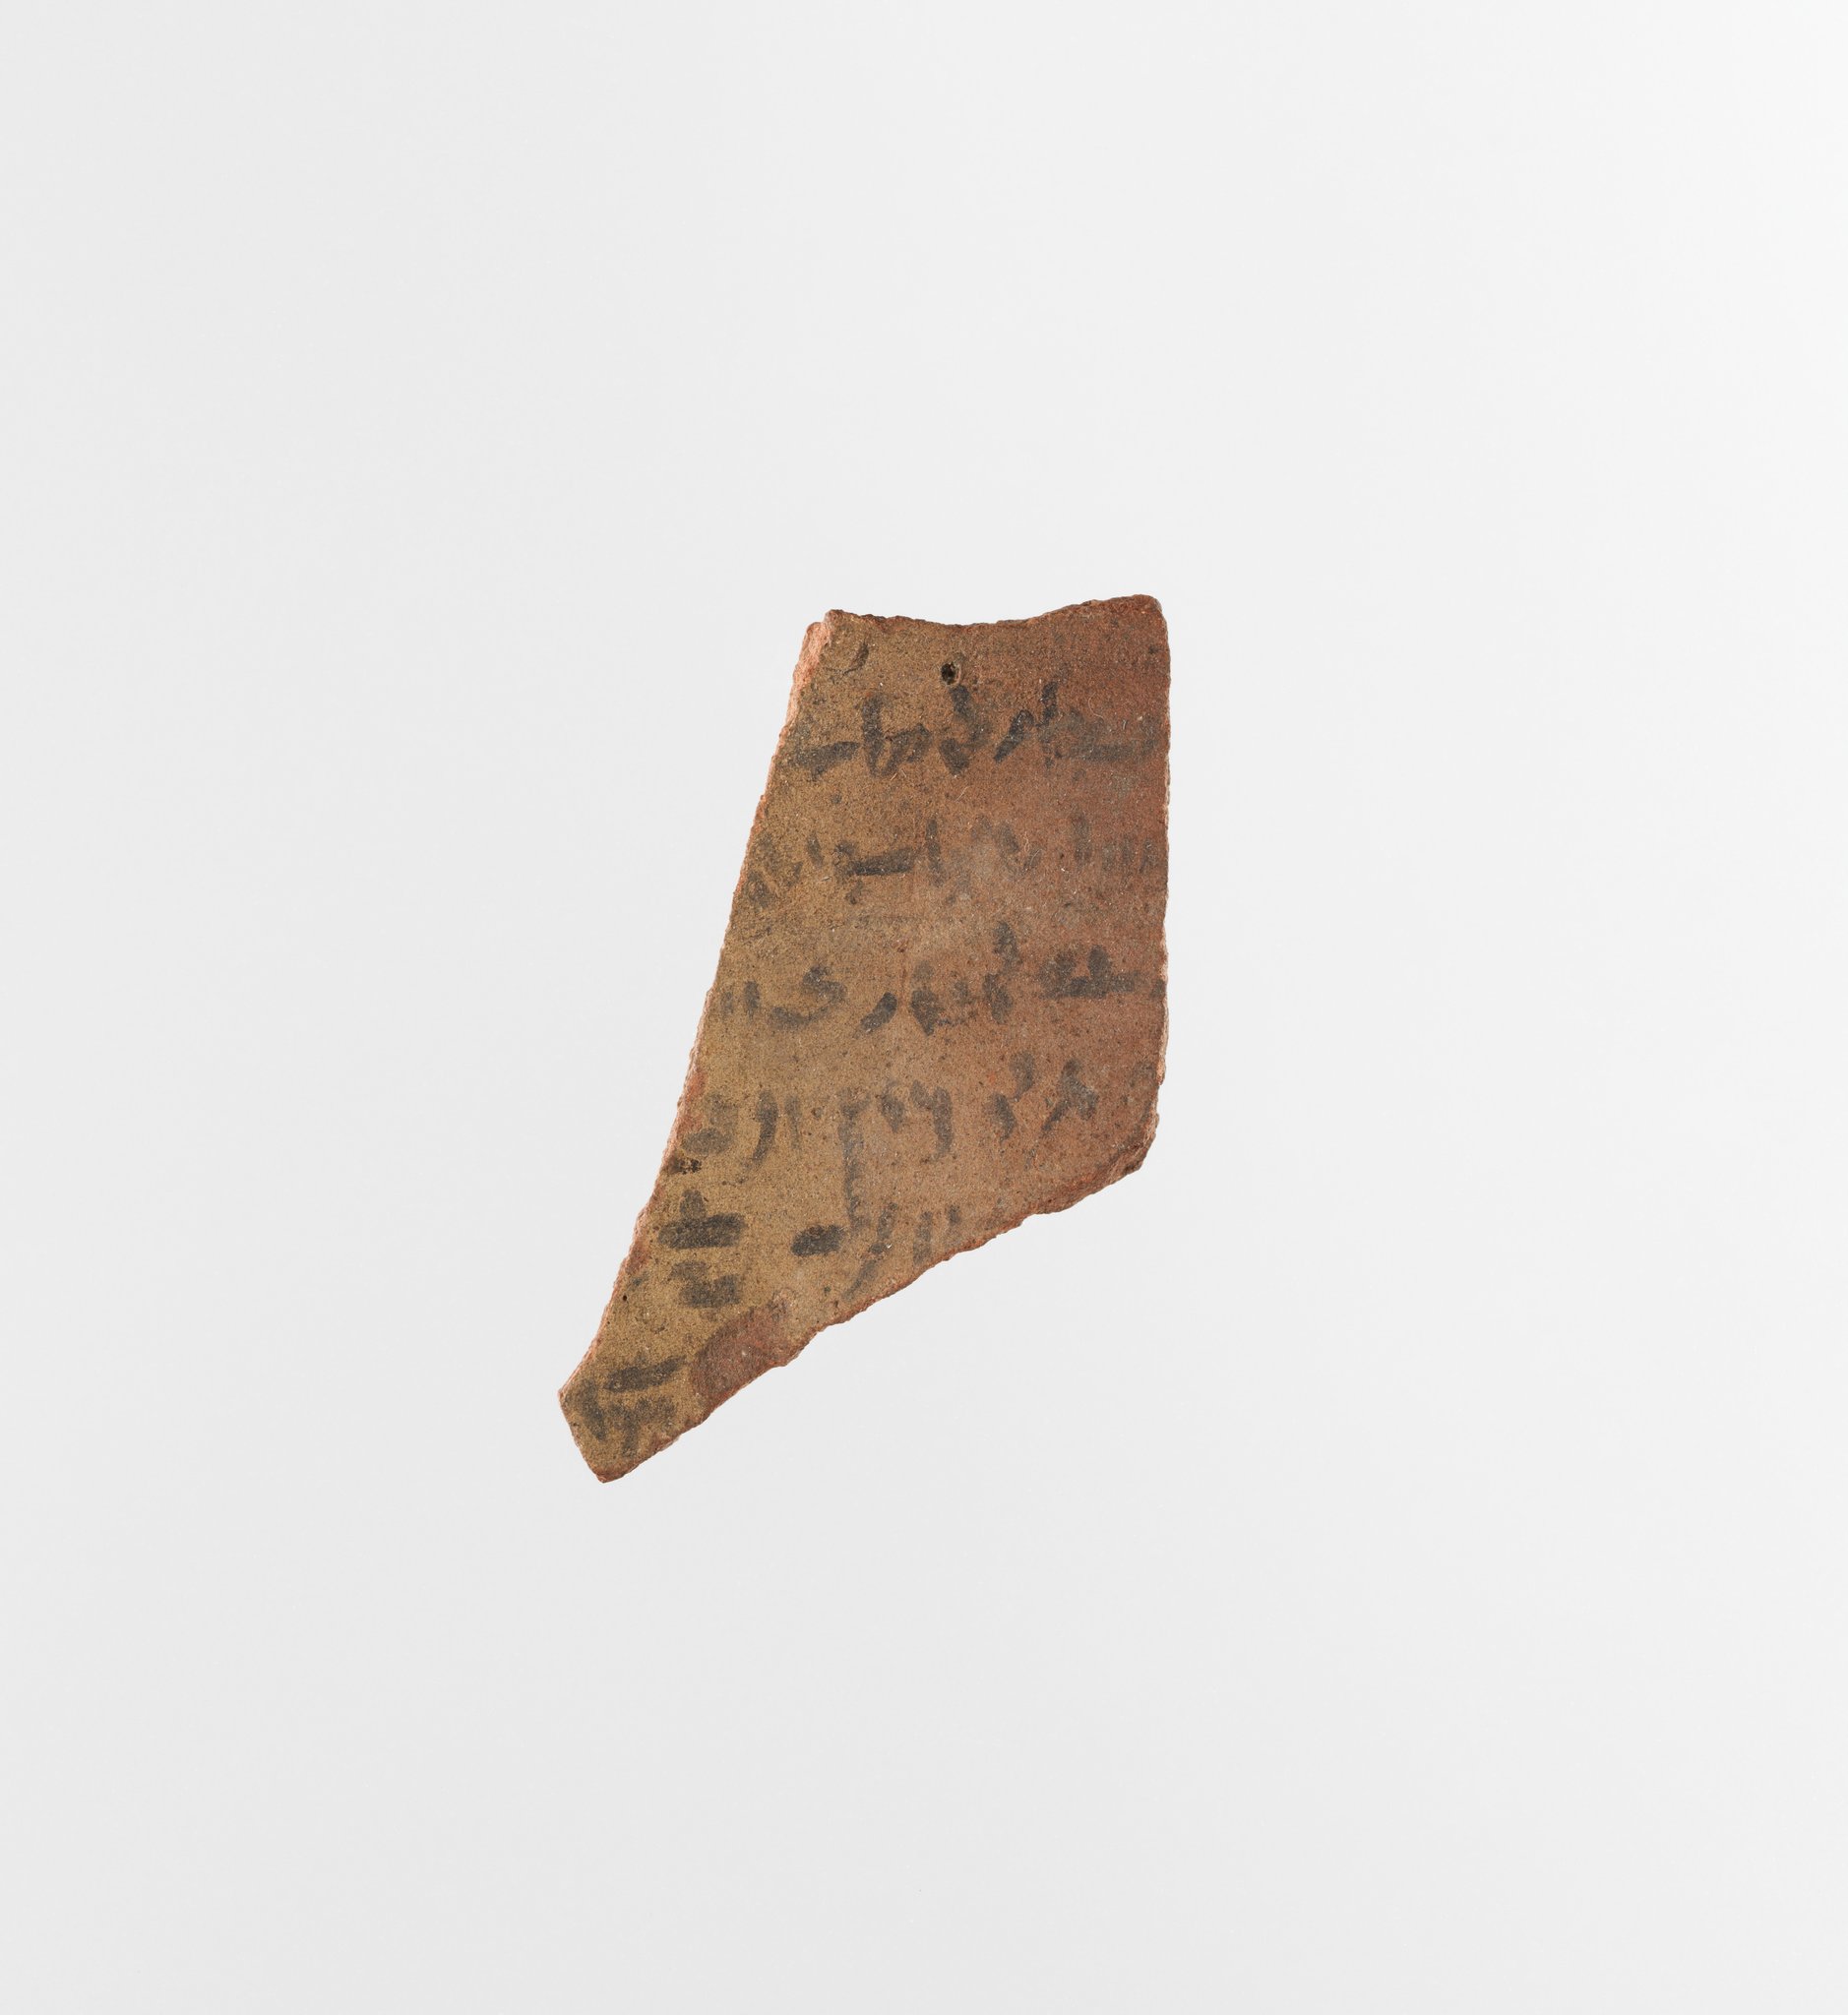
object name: ostracon, demotic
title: Ostracon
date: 600-30 BCE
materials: ink, pottery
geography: egypt